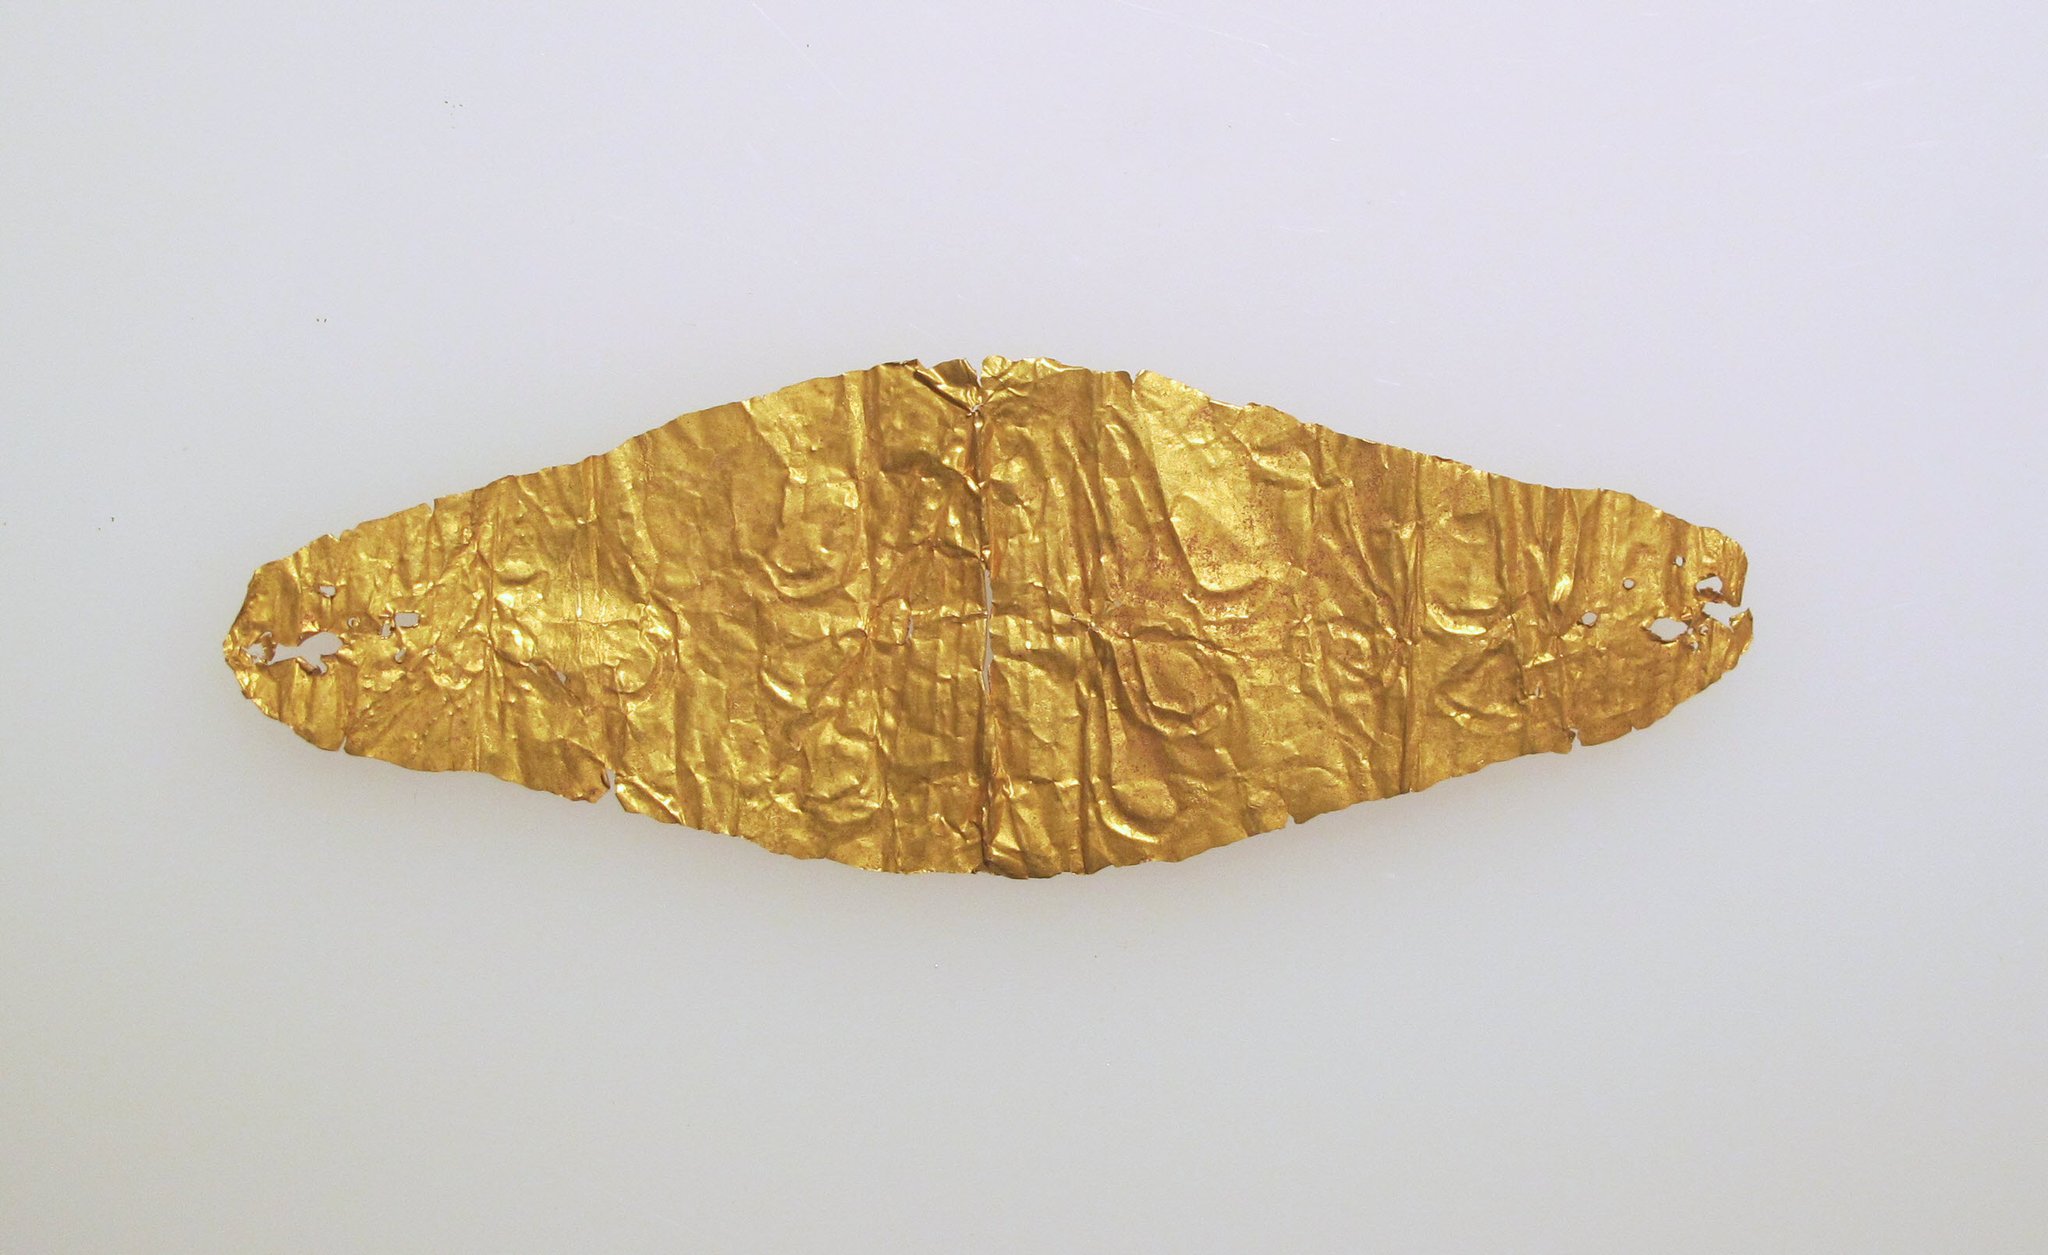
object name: frontlet of gold leaf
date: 7000 BCE-330 CE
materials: gold